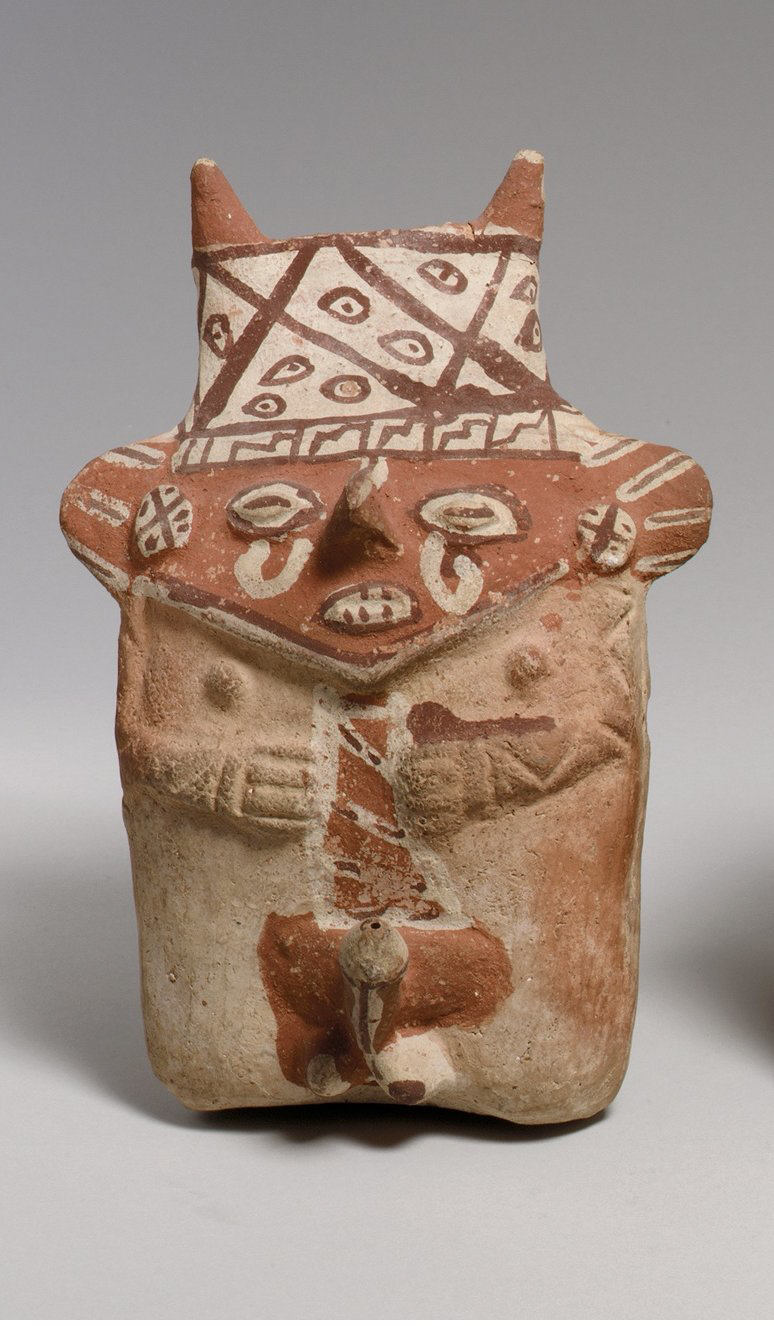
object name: figure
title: Male Figure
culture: chancay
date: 1101-1400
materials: ceramic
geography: peru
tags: men